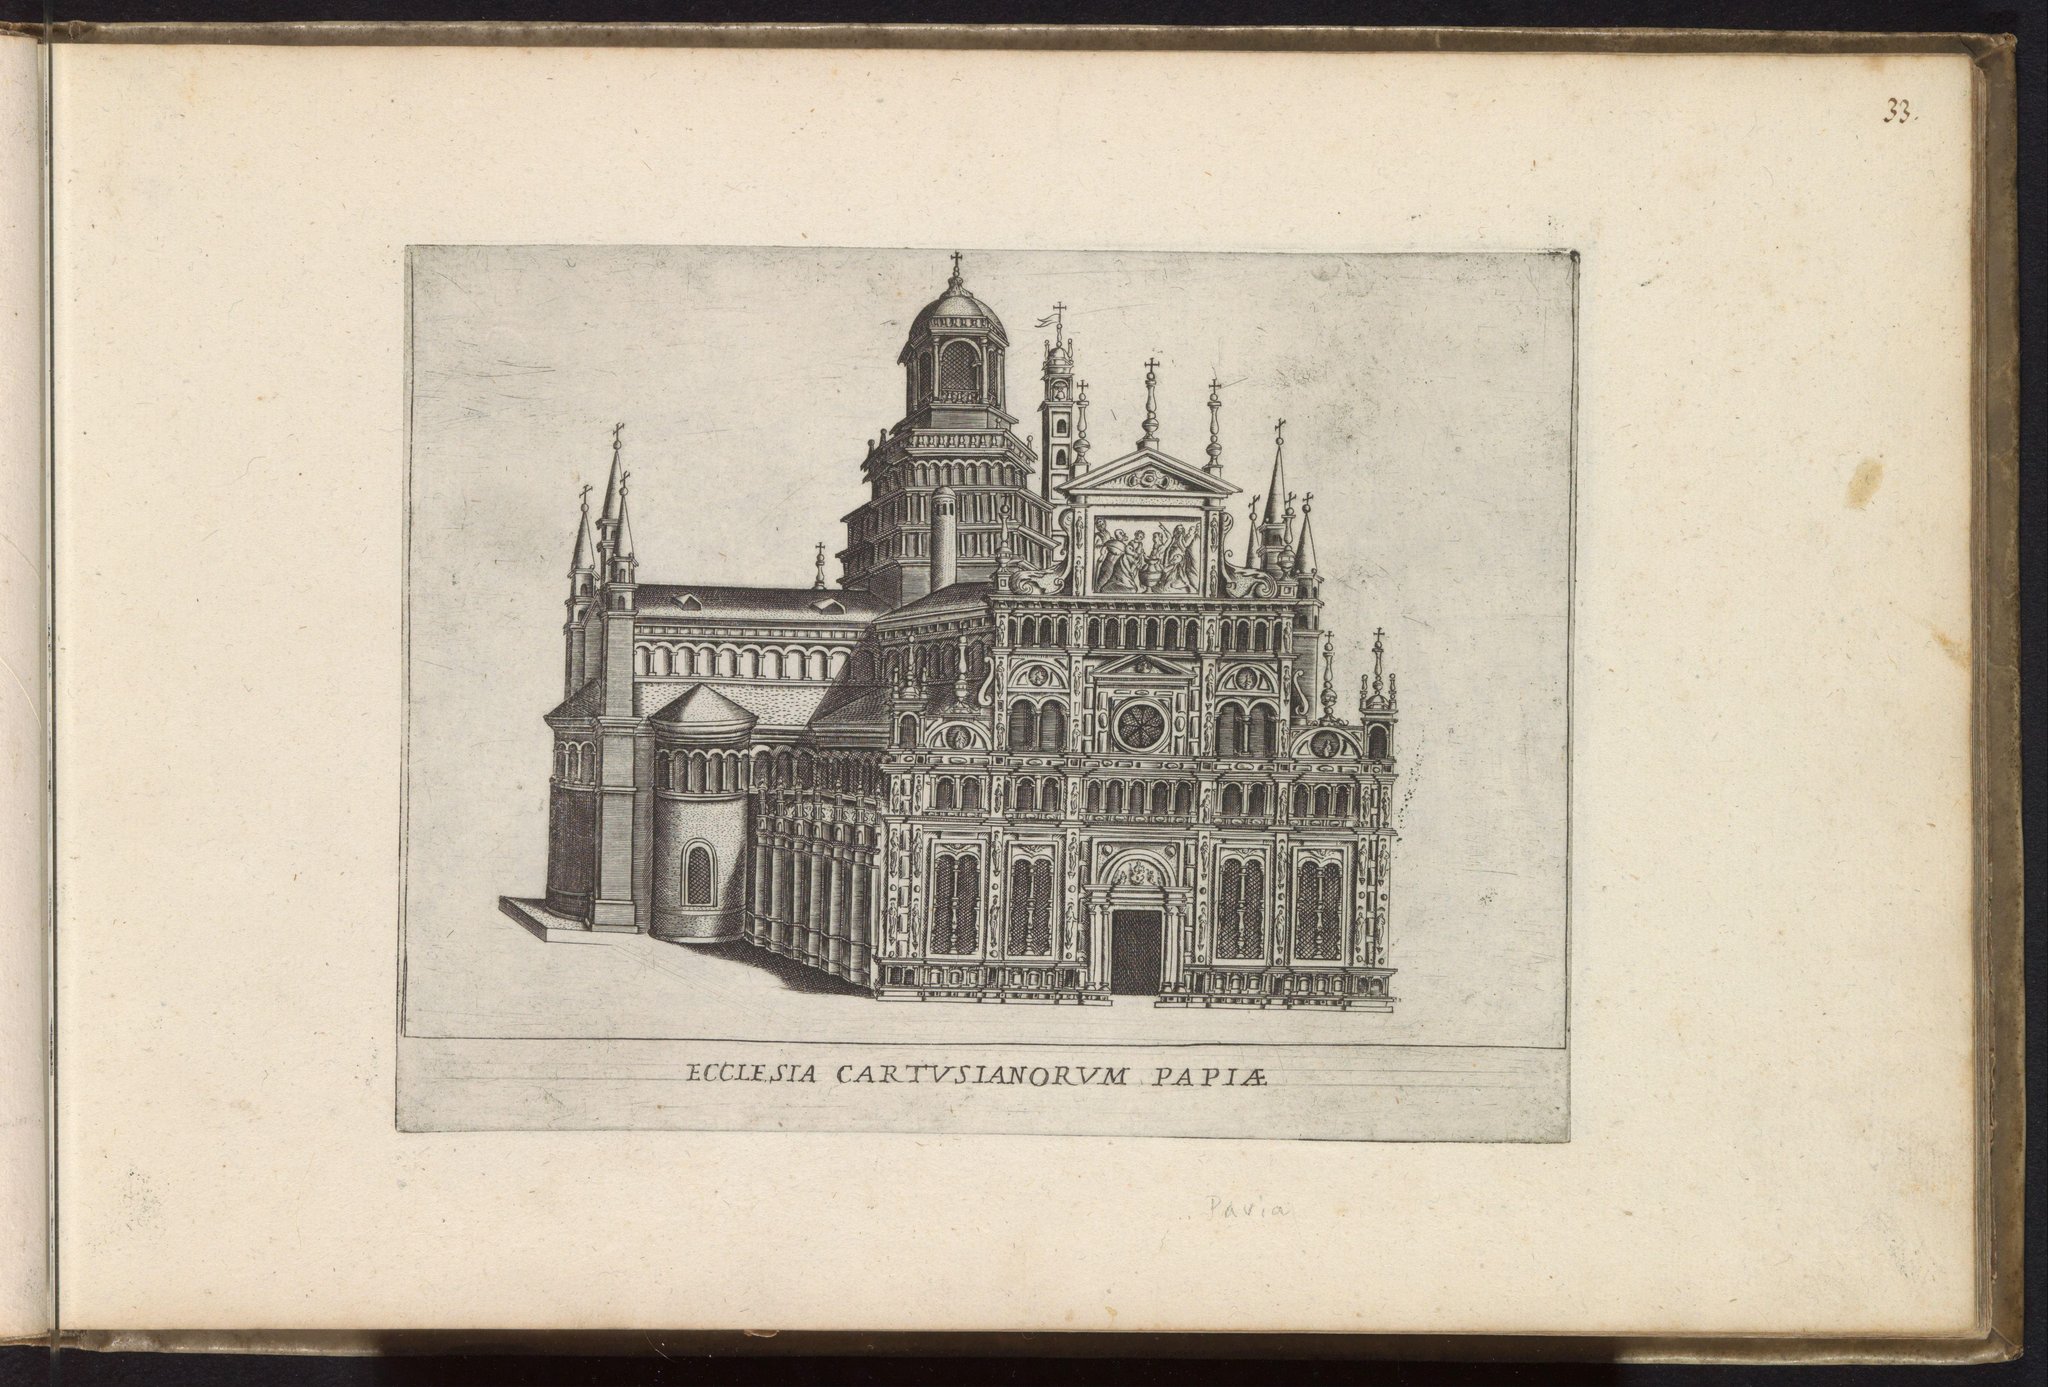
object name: album leaf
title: Certosa di Pavia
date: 1638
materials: paper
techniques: etching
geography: rome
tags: church (exterior)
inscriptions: number: ‘33’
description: Gezicht op de kerk van het klooster Certosa di Pavia in Lombardije. Prent maakt deel uit van een album.